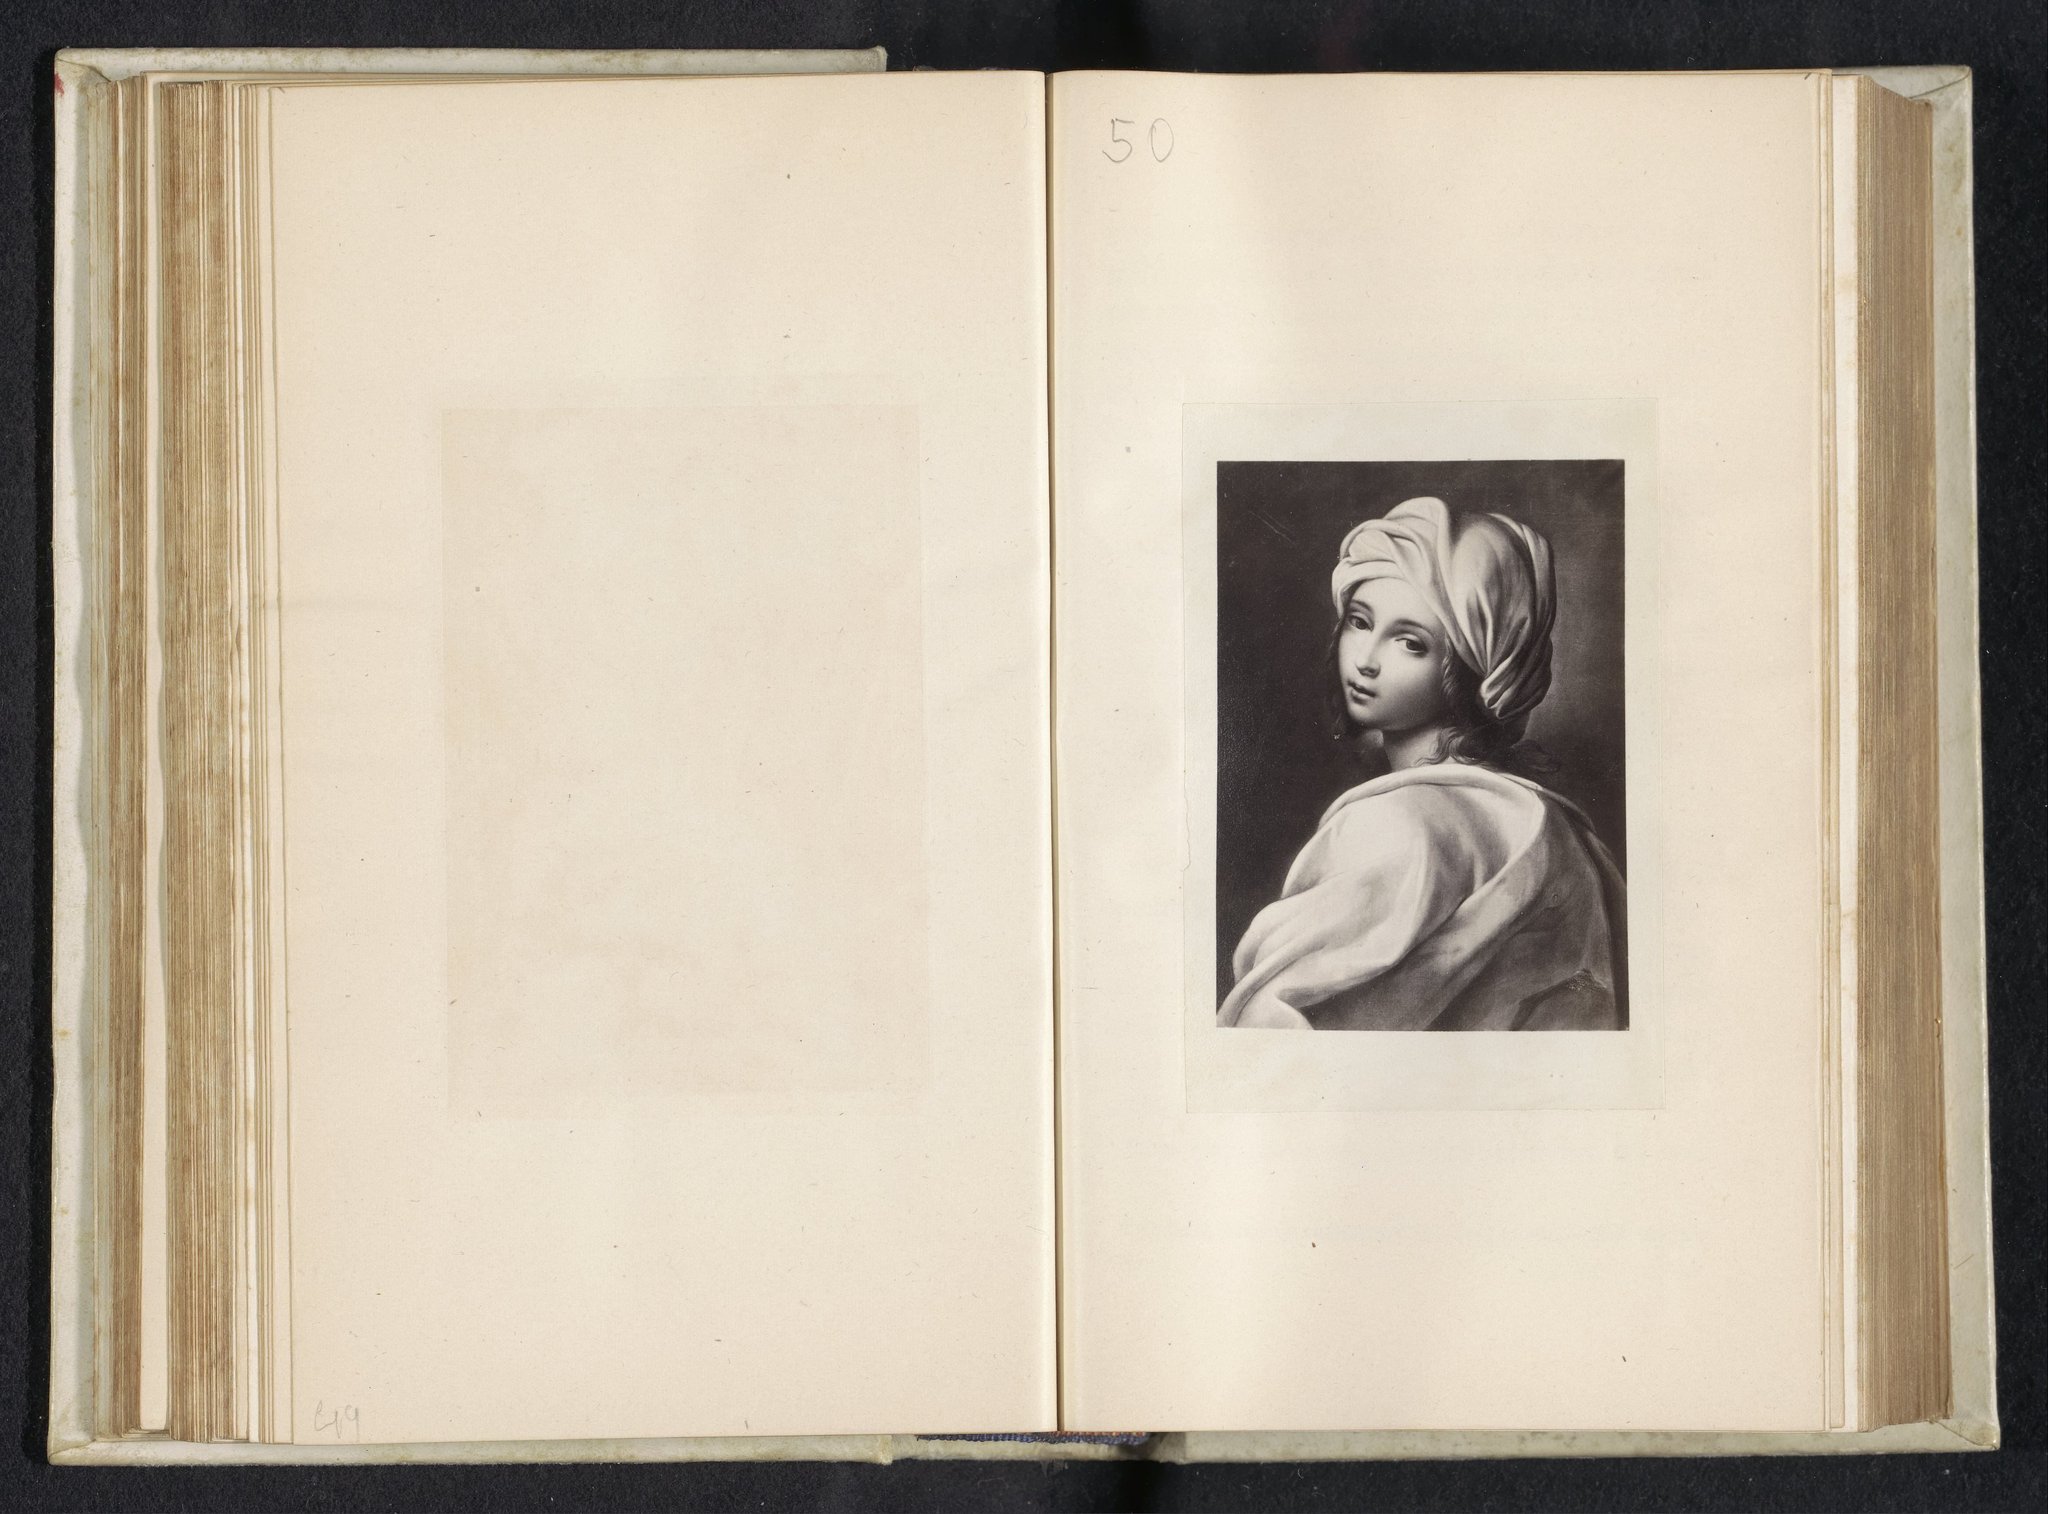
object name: photograph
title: Fotoreproductie van een schilderij, voorstellende een portret van Beatrice Cenci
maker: Anonymous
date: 1850-1860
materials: photographic support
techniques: albumen print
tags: adult woman